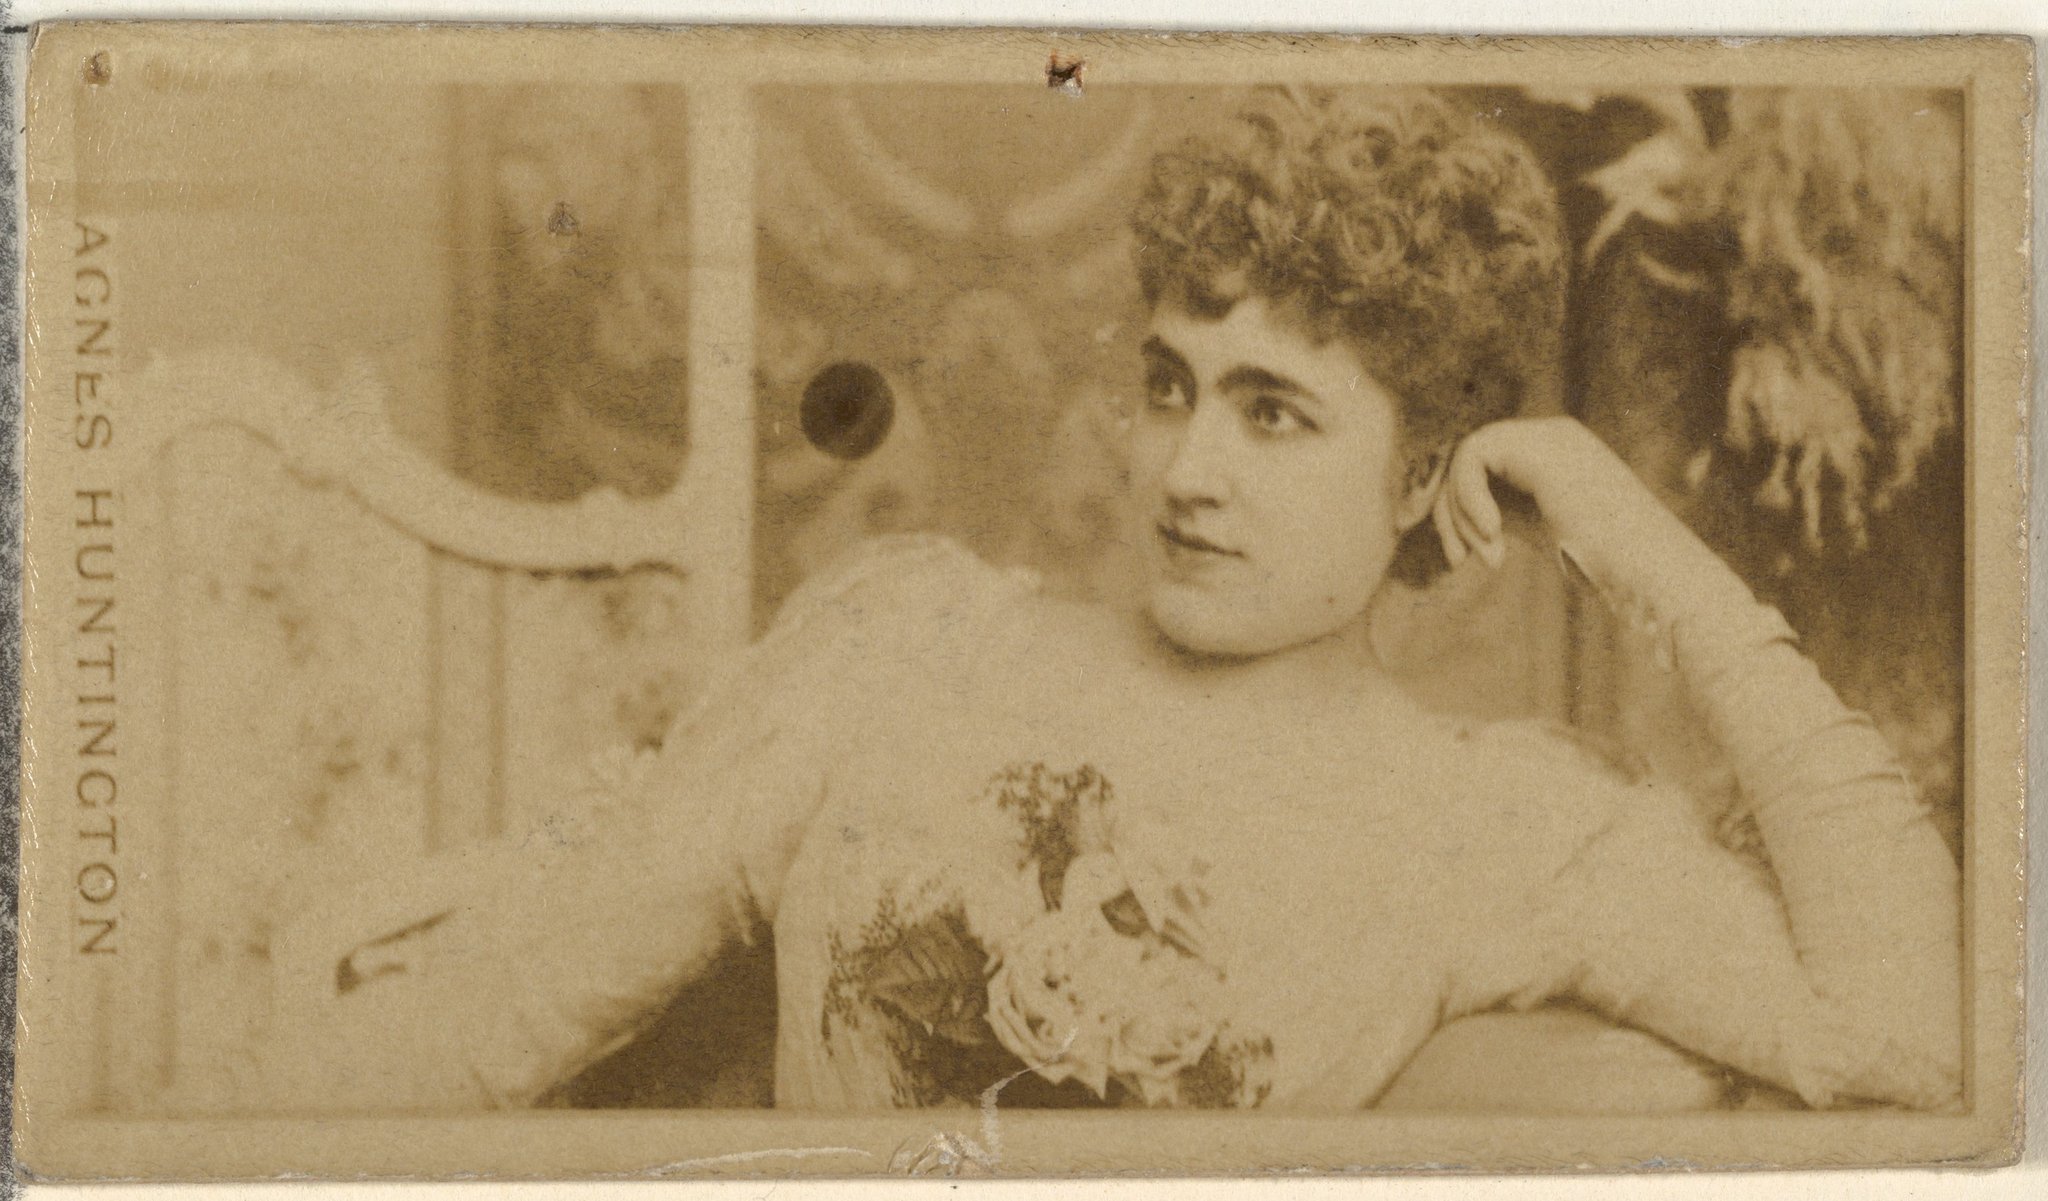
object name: photograph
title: Agnes Huntington, from the Actors and Actresses series (N145-8) issued by Duke Sons & Co. to promote Duke Cigarettes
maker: w. duke, sons & co.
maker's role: publisher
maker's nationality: american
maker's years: 1870-1920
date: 1891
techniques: albumen silver print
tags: portraits,women,actresses